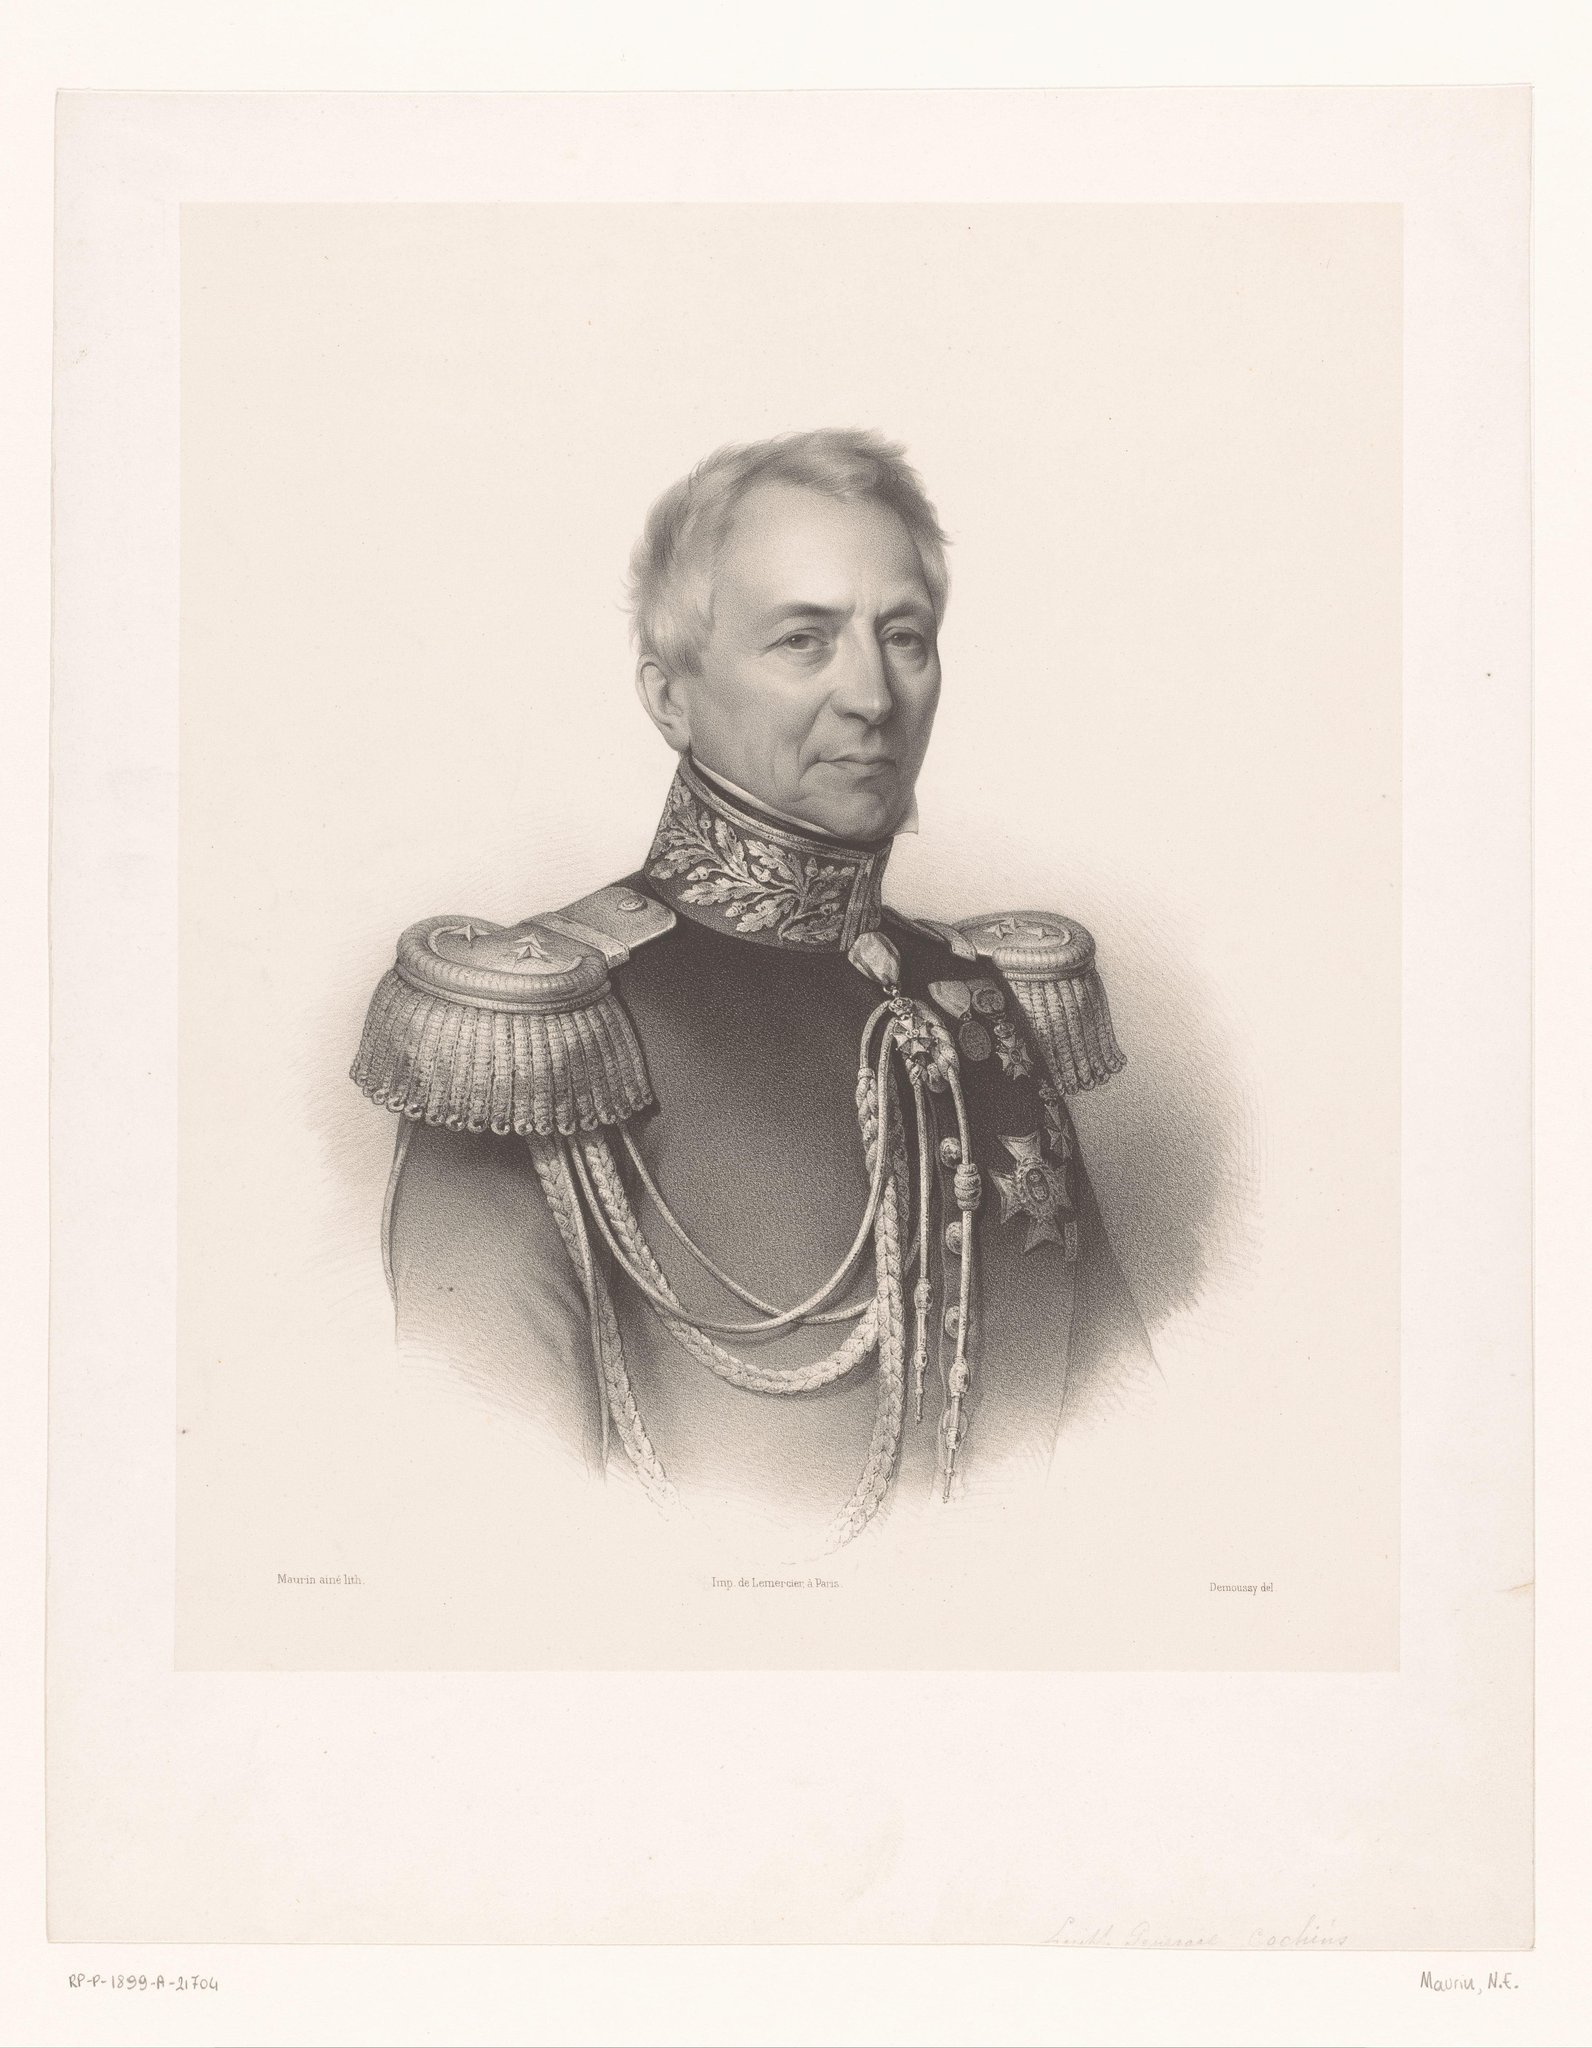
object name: print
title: Portret van Frans David Cochius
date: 1848-1887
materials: paper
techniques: lithograph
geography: paris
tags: commander-in-chief, general, marshal, historical persons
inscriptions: collector's mark: Lugt 2228